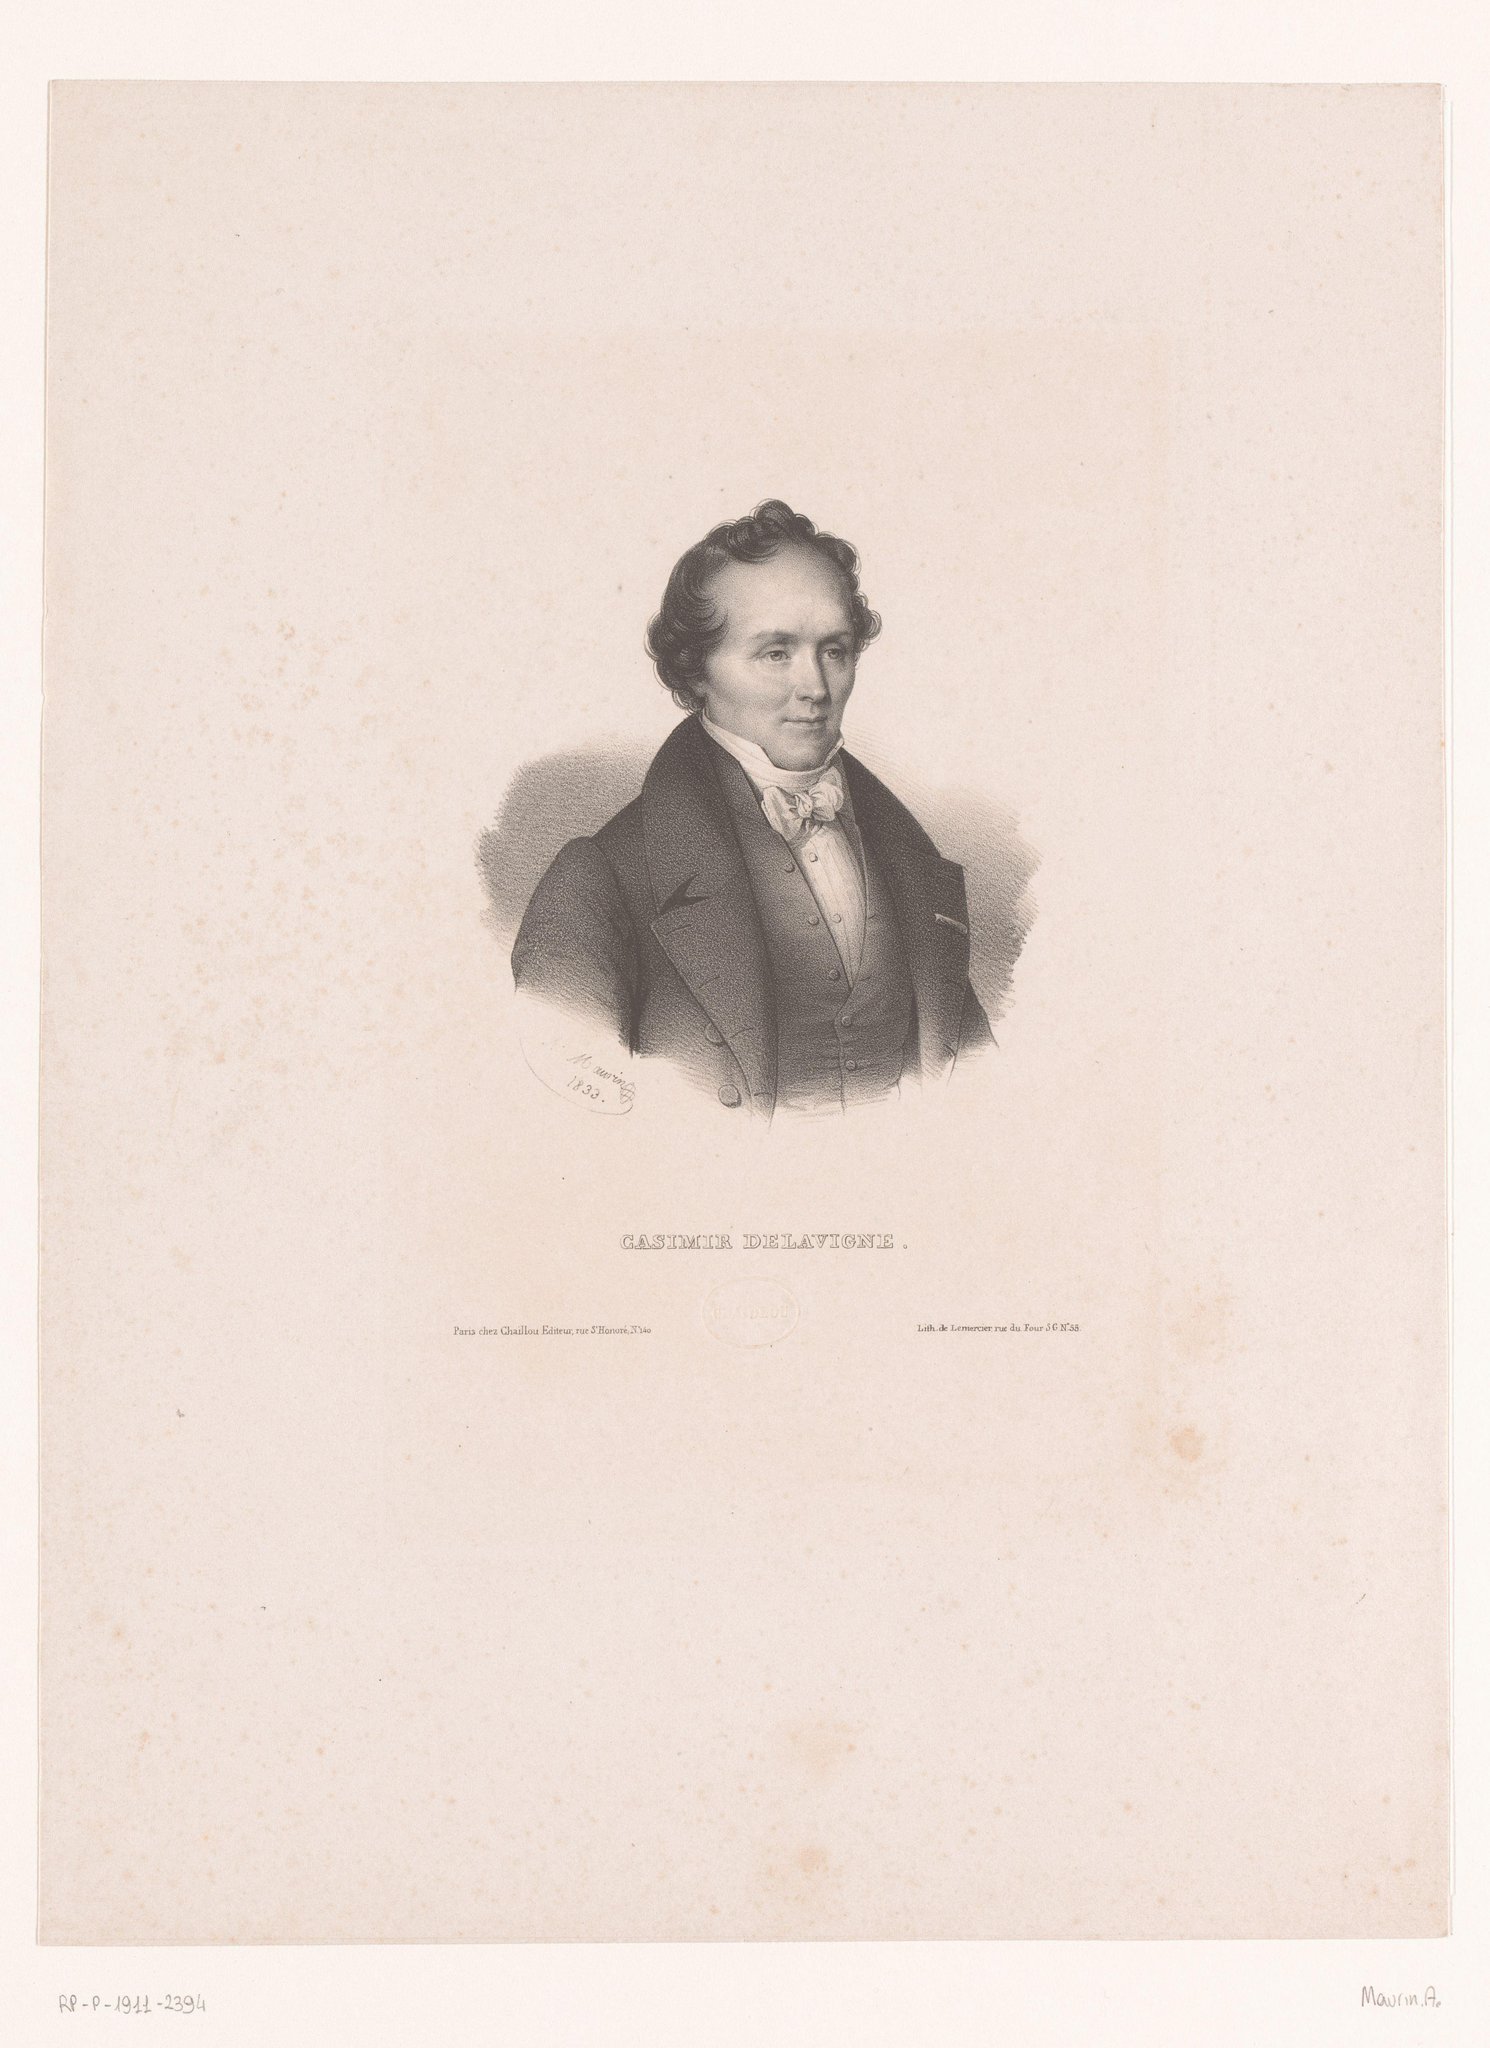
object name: print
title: Casimir Delavigne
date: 1833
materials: paper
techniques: lithograph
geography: paris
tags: historical persons, writer, poet, author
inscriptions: collector's mark: Lugt 2228, check stamp: Lugt 4733